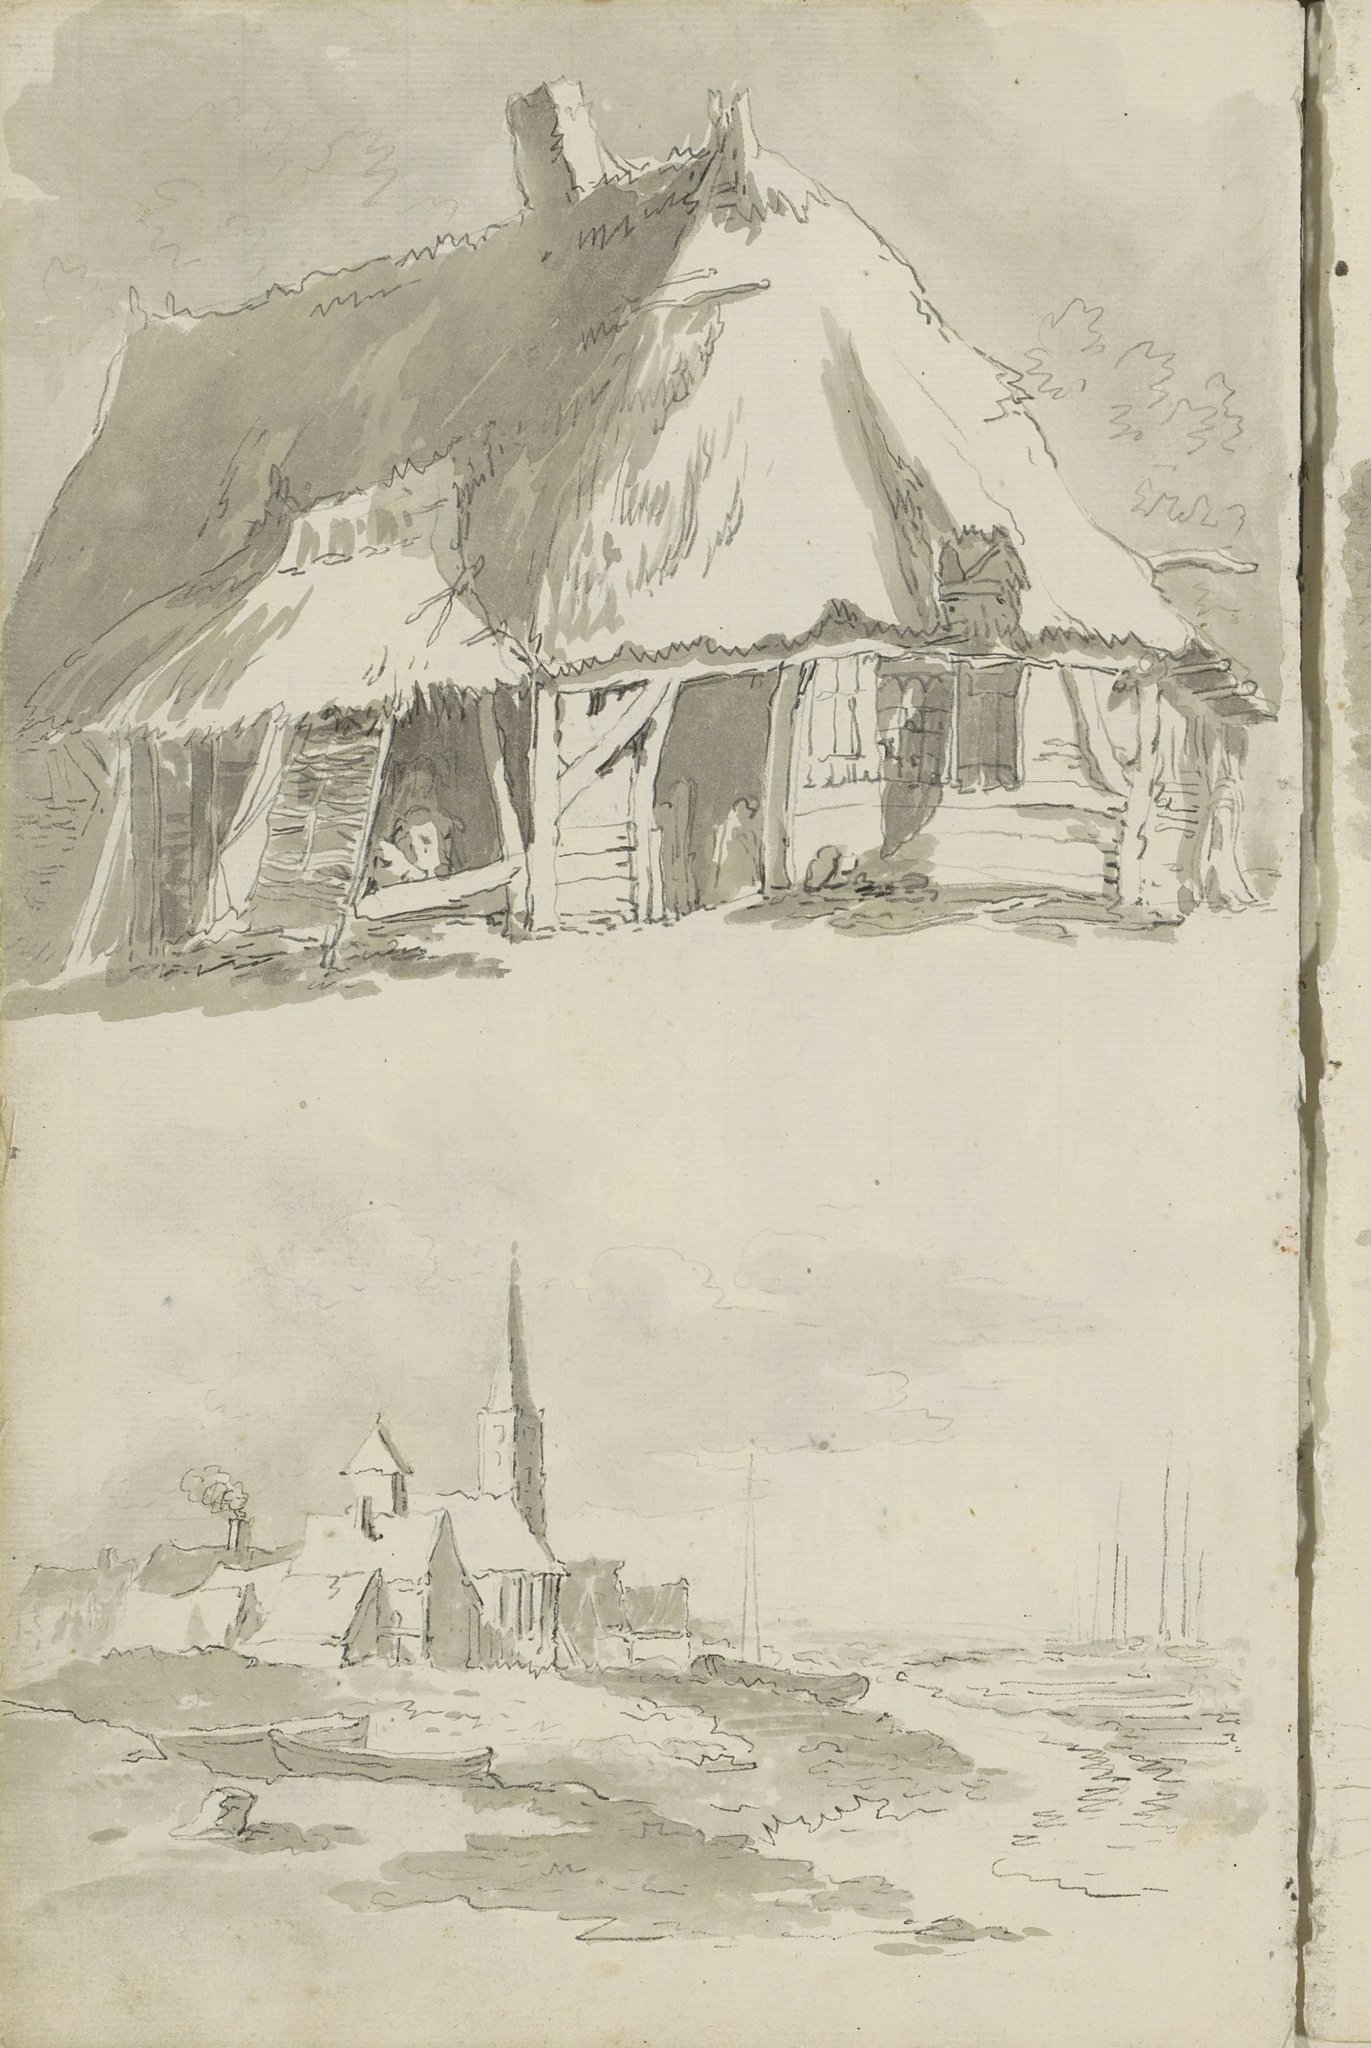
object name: sketchbook leaf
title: Boerenschuur en gezicht op een stad aan het water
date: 1780-1800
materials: paper, pencil, watercolor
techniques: brush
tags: barn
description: Blad 6 verso uit een schetsboek met 25 bladen.